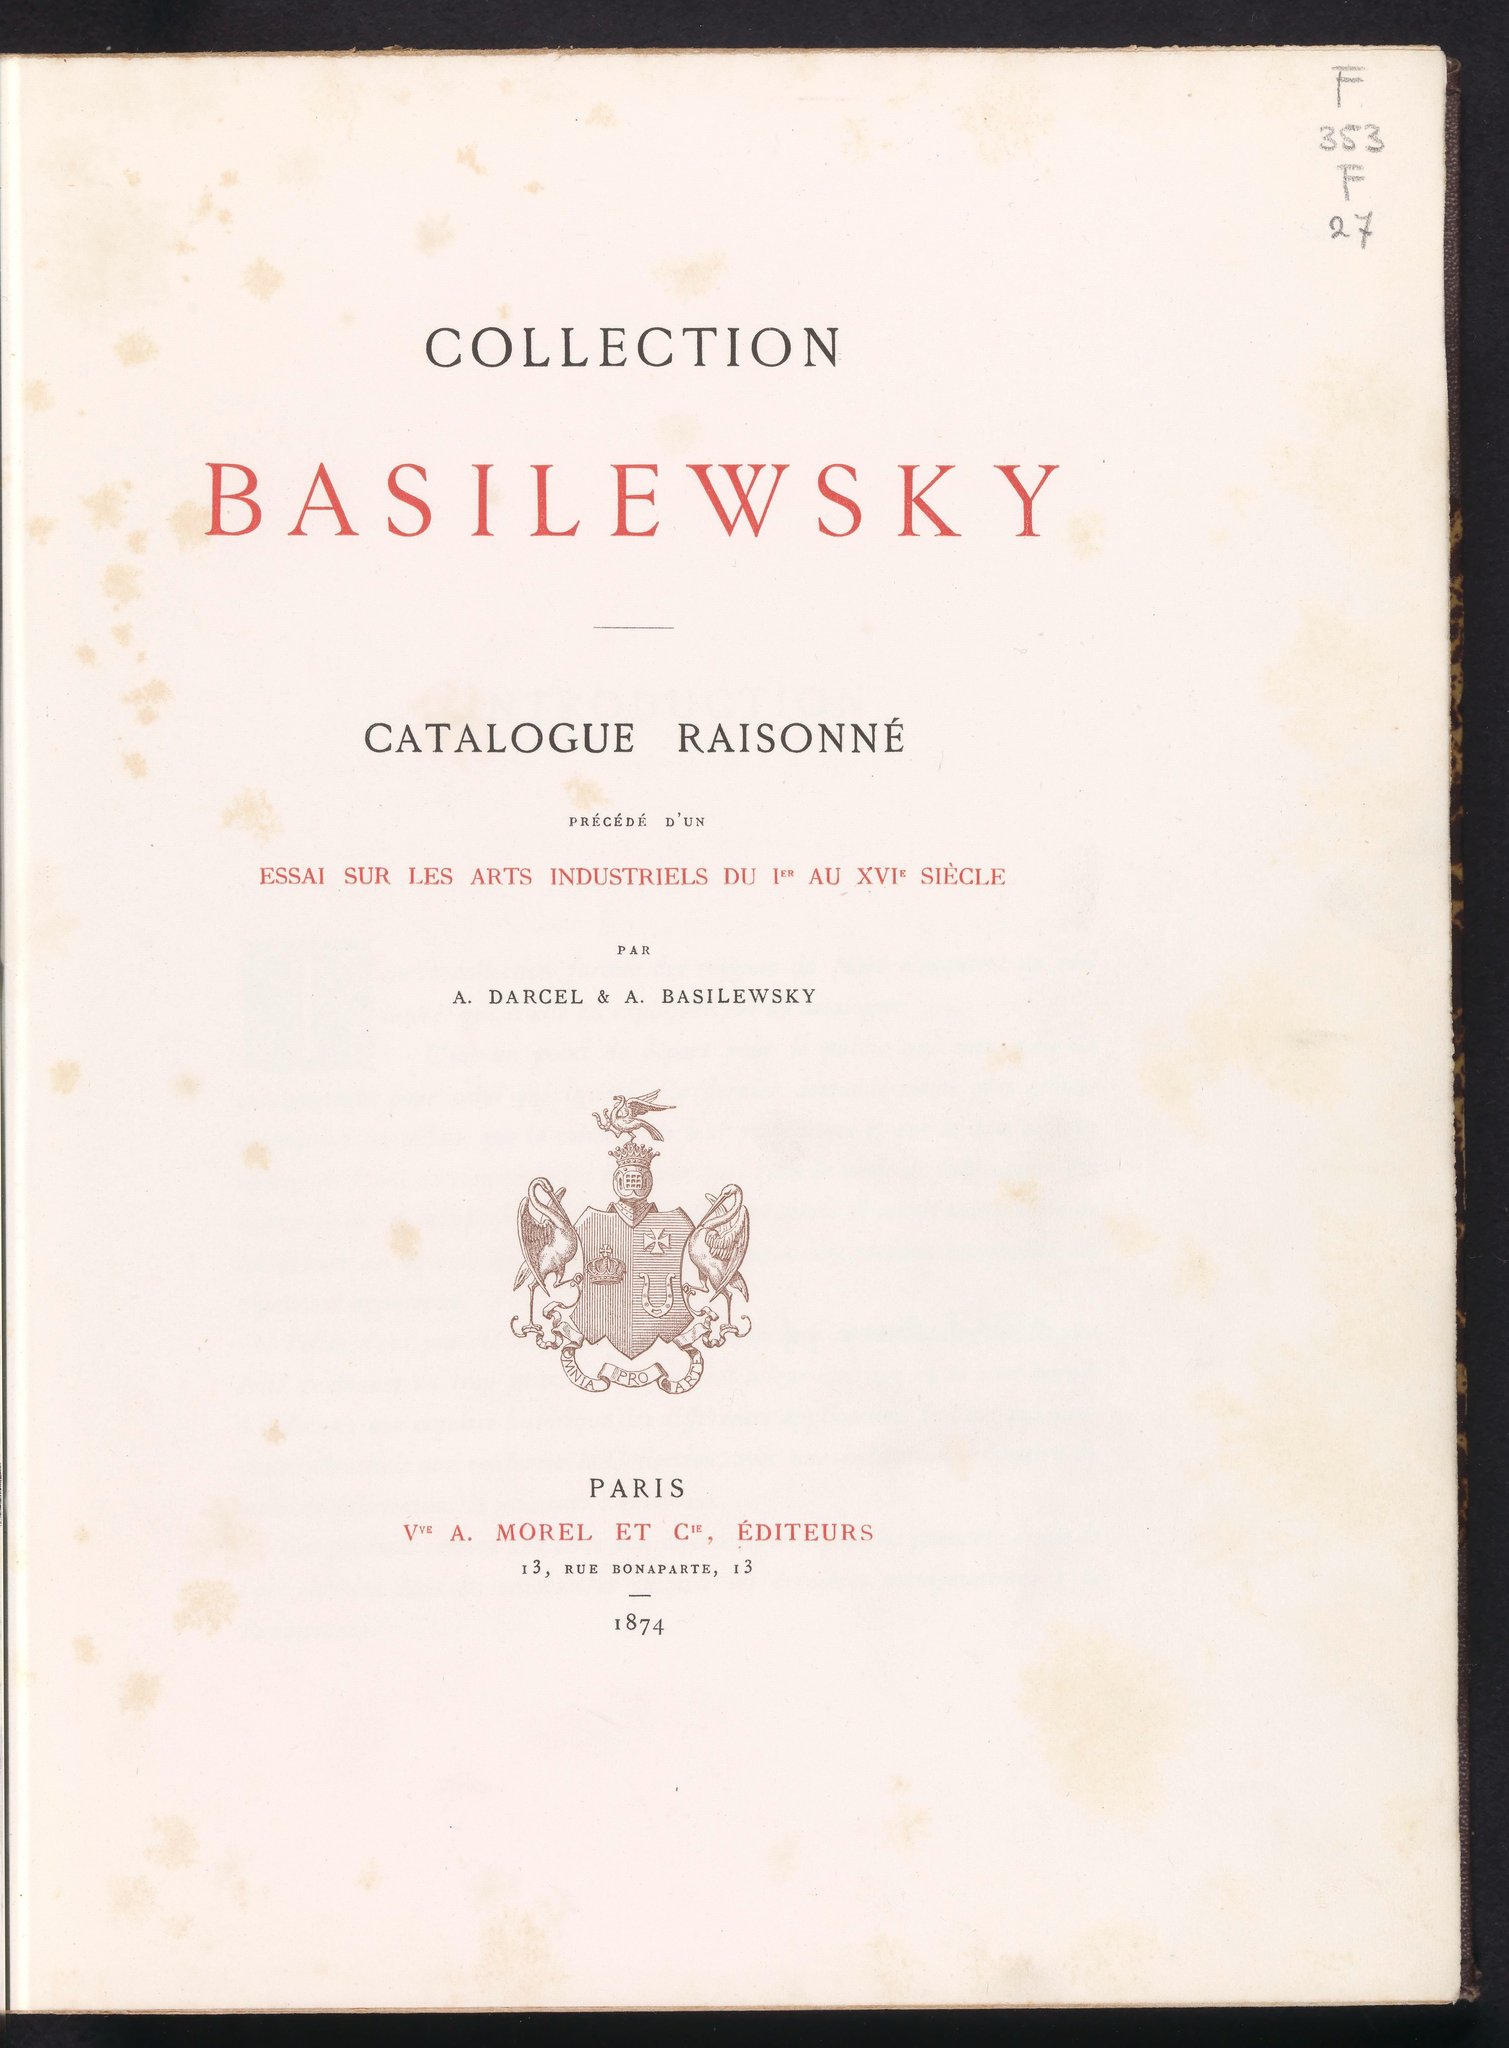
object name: book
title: Collection Basilewsky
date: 1874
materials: cardboard, linen, paper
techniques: marbled paper, lithograph, photoaquatint, printing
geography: paris